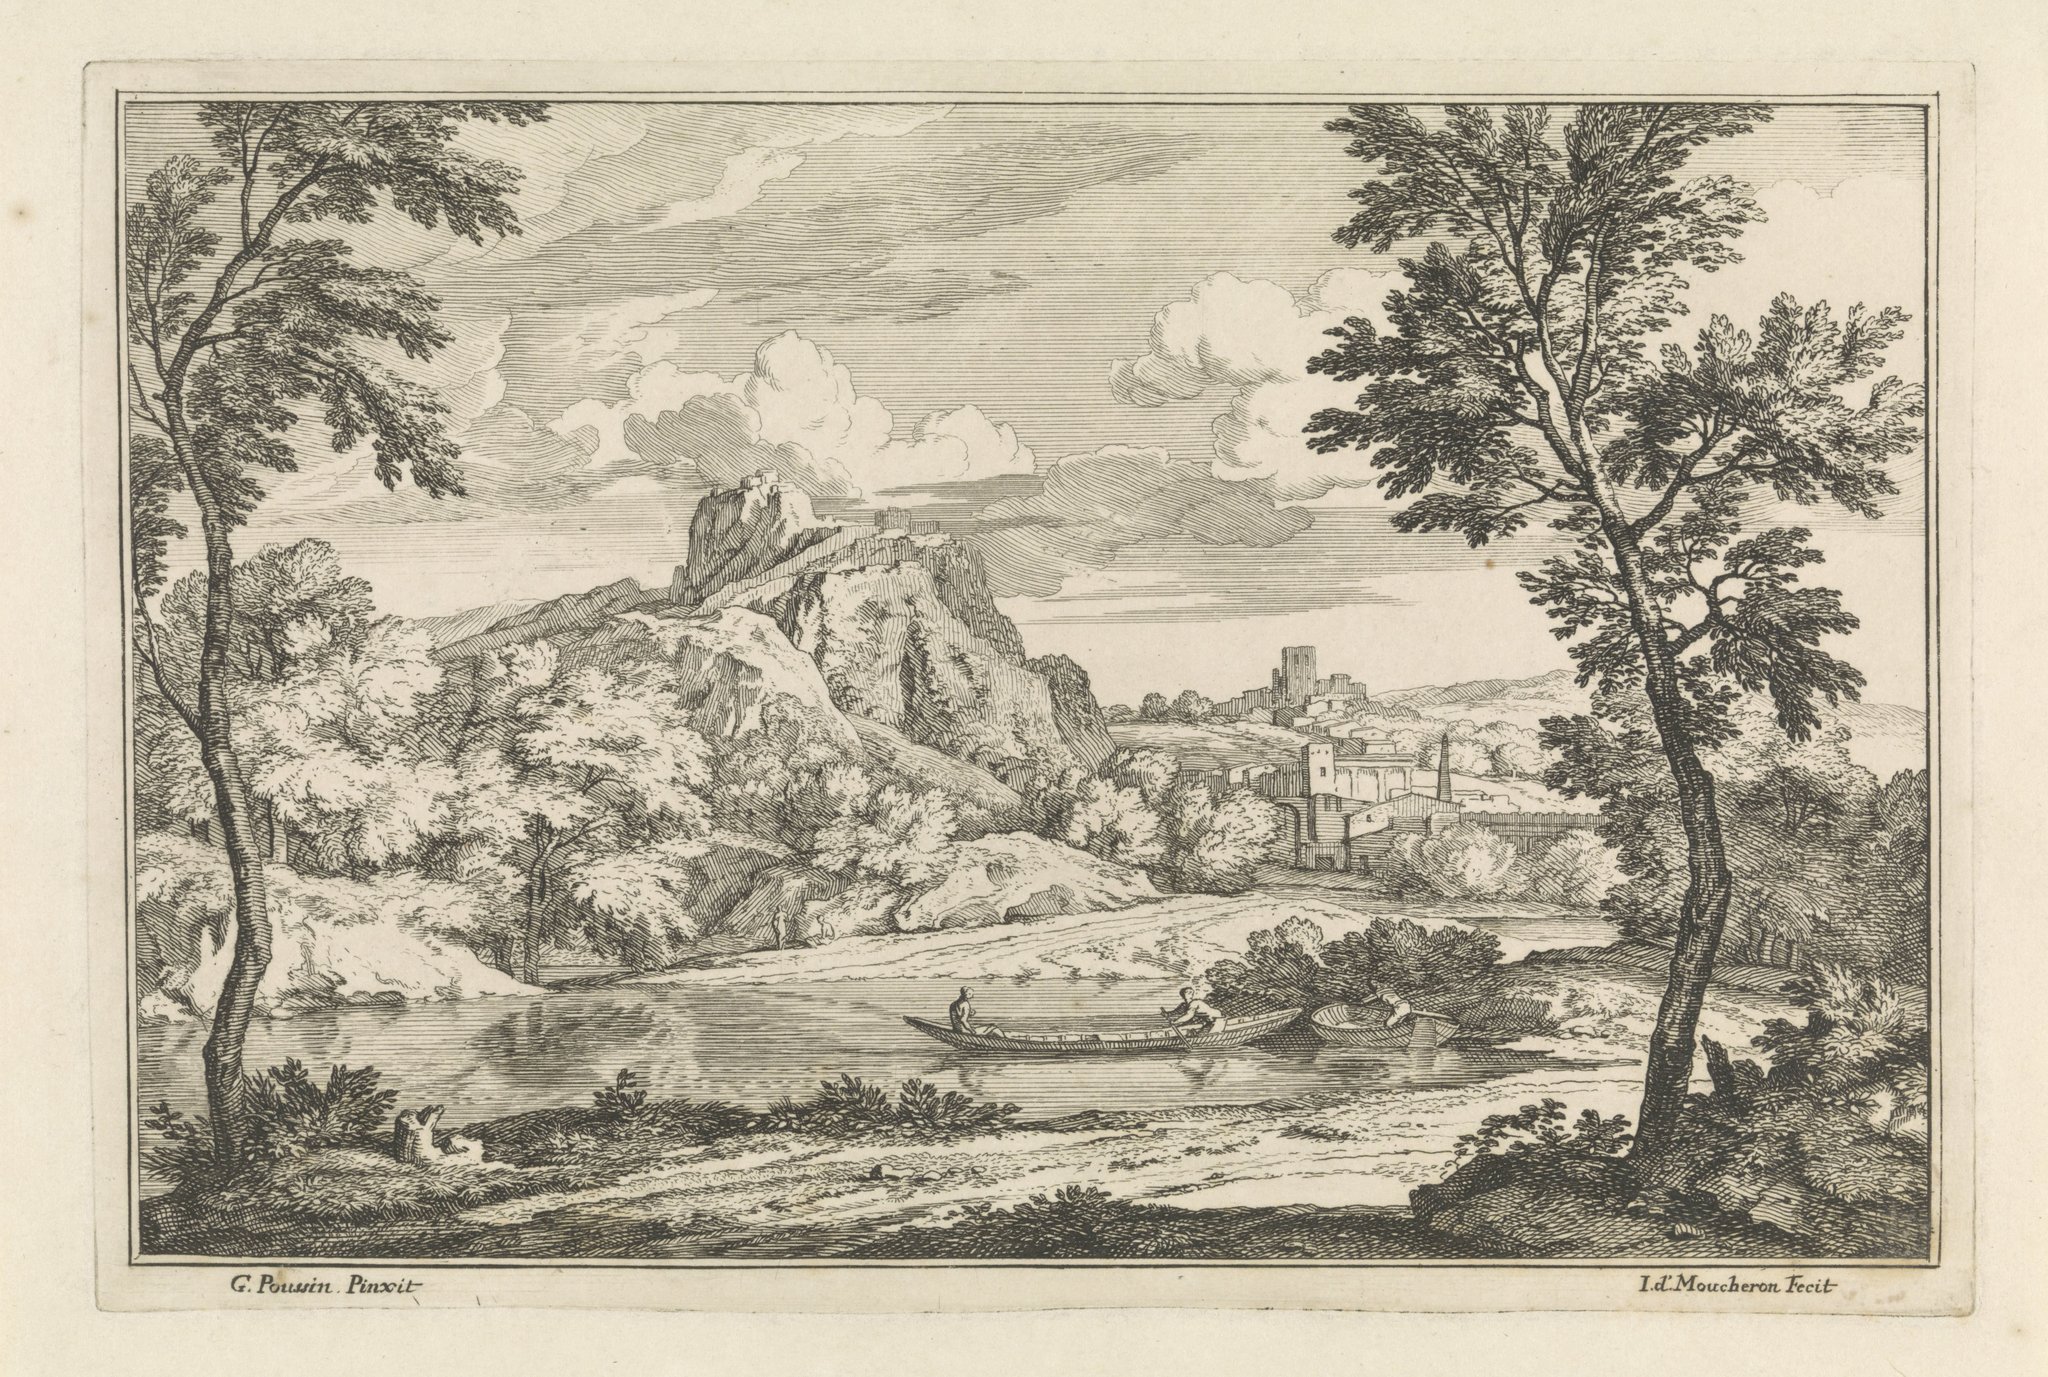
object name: print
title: Arcadische landschappen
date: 1697-1744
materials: paper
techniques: engraving, etching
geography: rome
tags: rowing-boat, canoe, etc., lake, pastorals, arcadian scenes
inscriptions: collector's mark: Lugt 240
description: Landschap met een meer en bergen en een stad op de achtergrond. Op het meer twee boten met figuren.